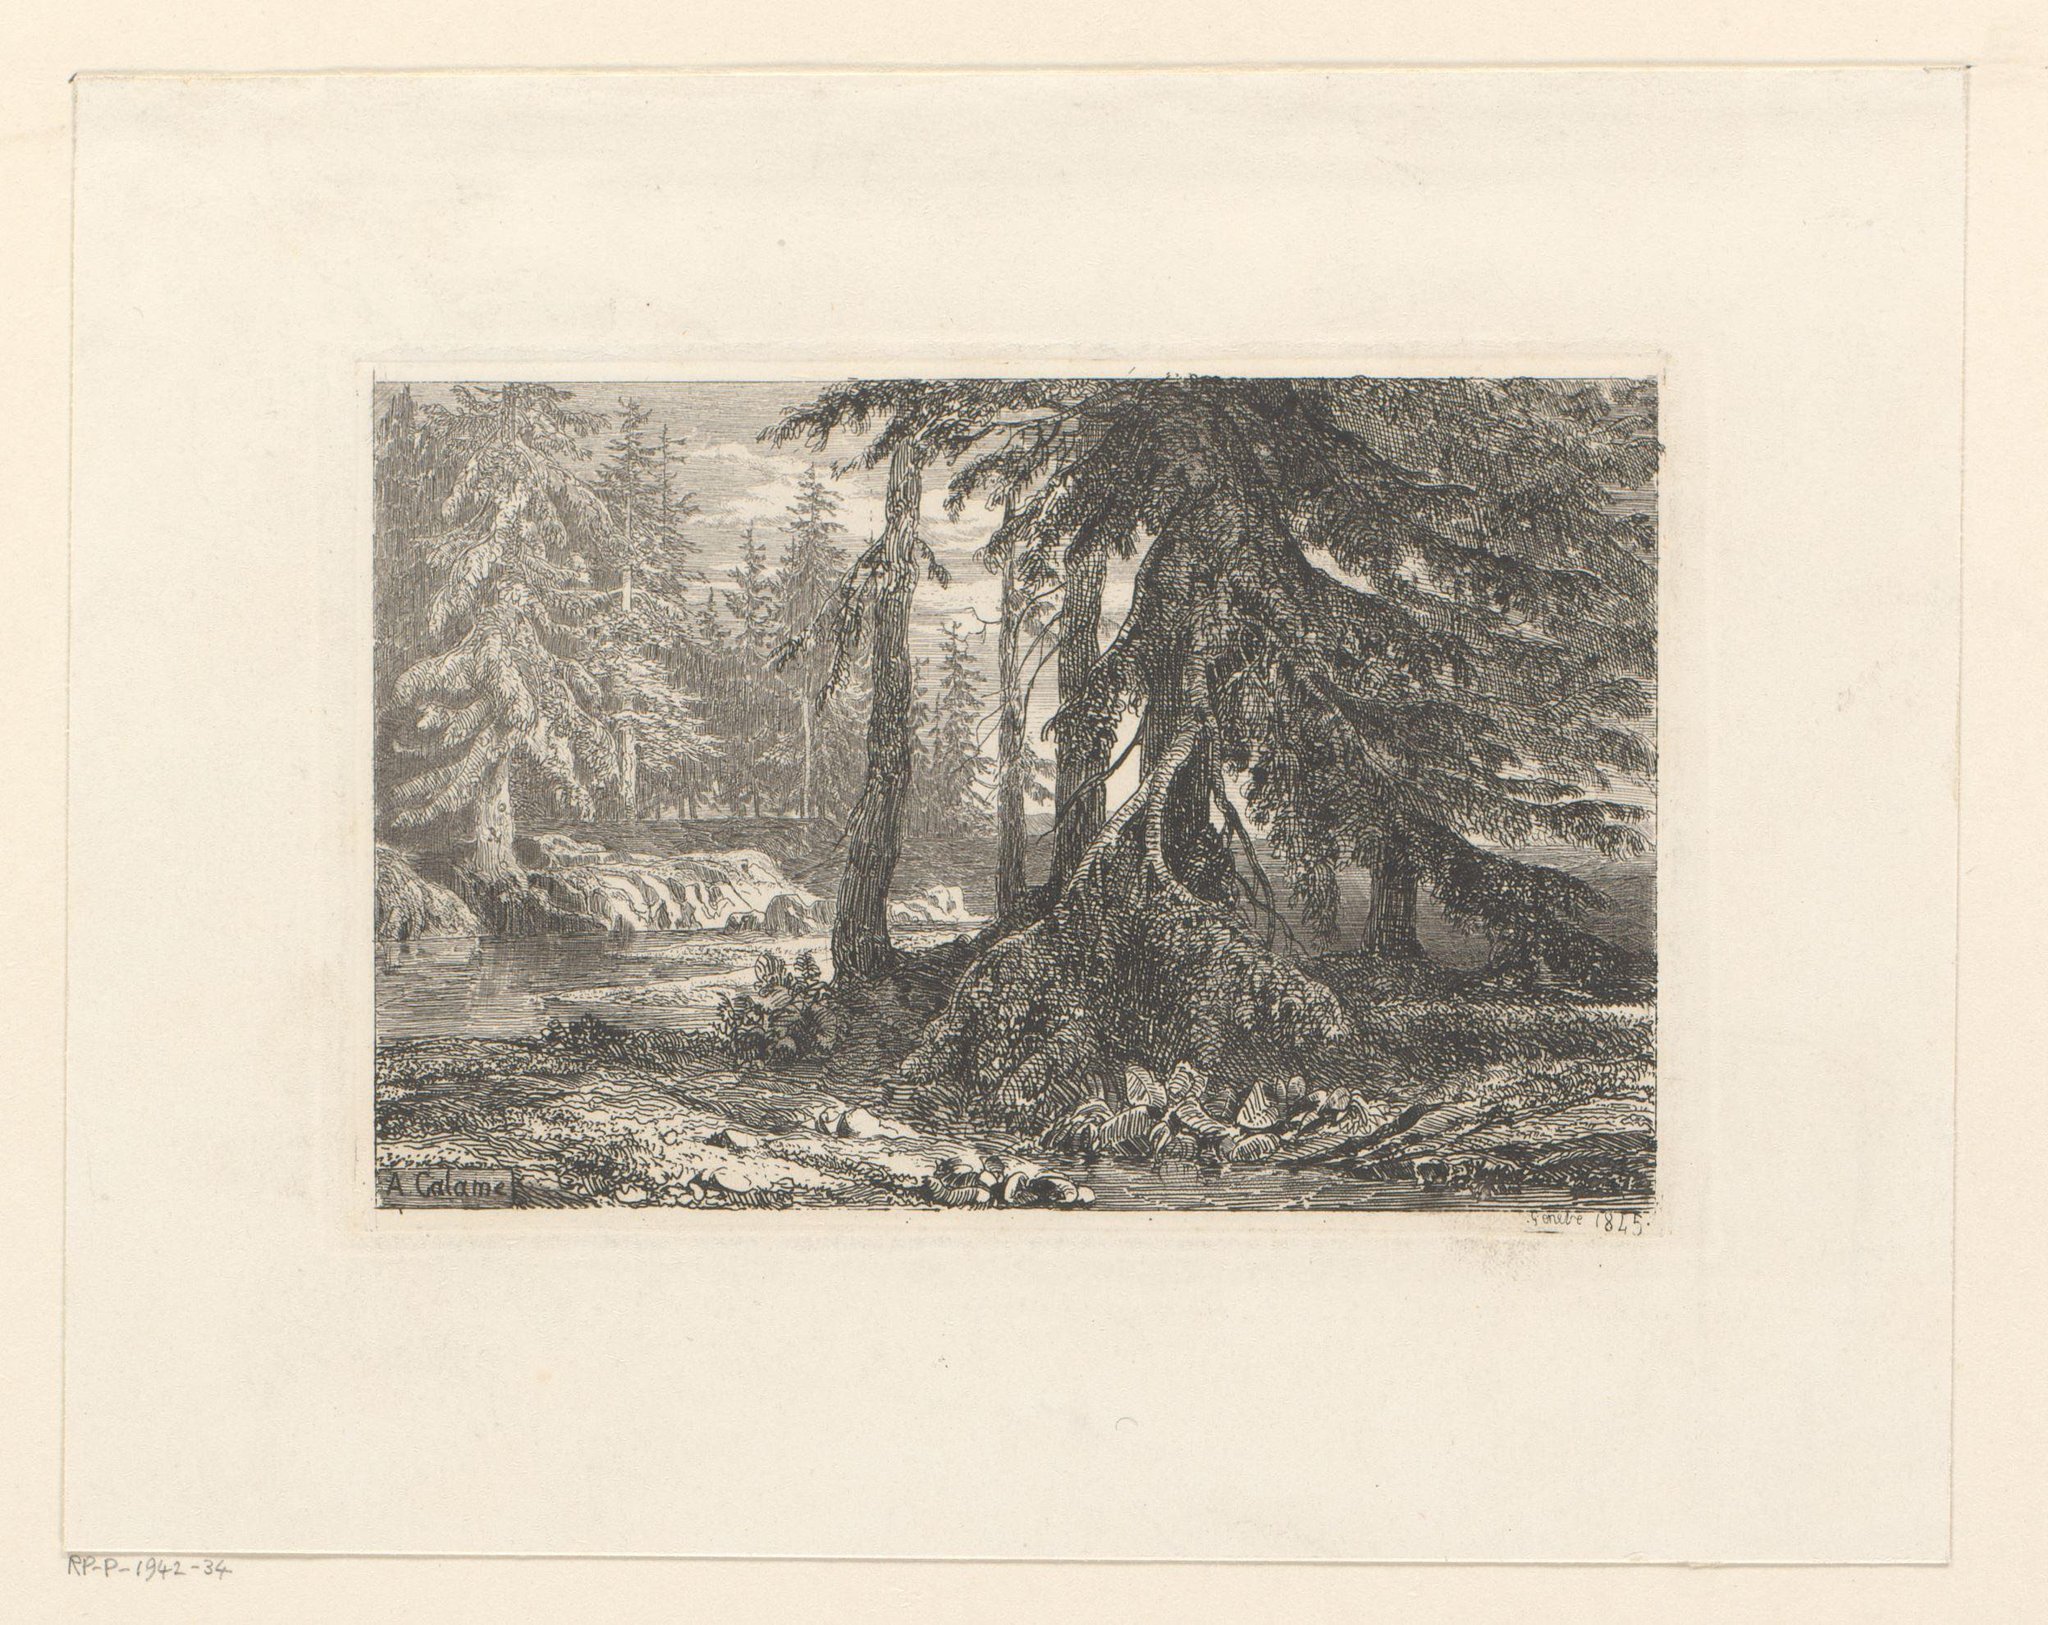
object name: print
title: Boslandschap met dennenbomen langs een rivier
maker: alexandre calame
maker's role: draughtsman, painter, print maker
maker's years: 1810-1864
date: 1845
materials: paper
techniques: etching, roulette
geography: geneva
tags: forest of coniferous trees, river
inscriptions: collector's mark: Lugt 2228, collector's mark: Lugt 2760